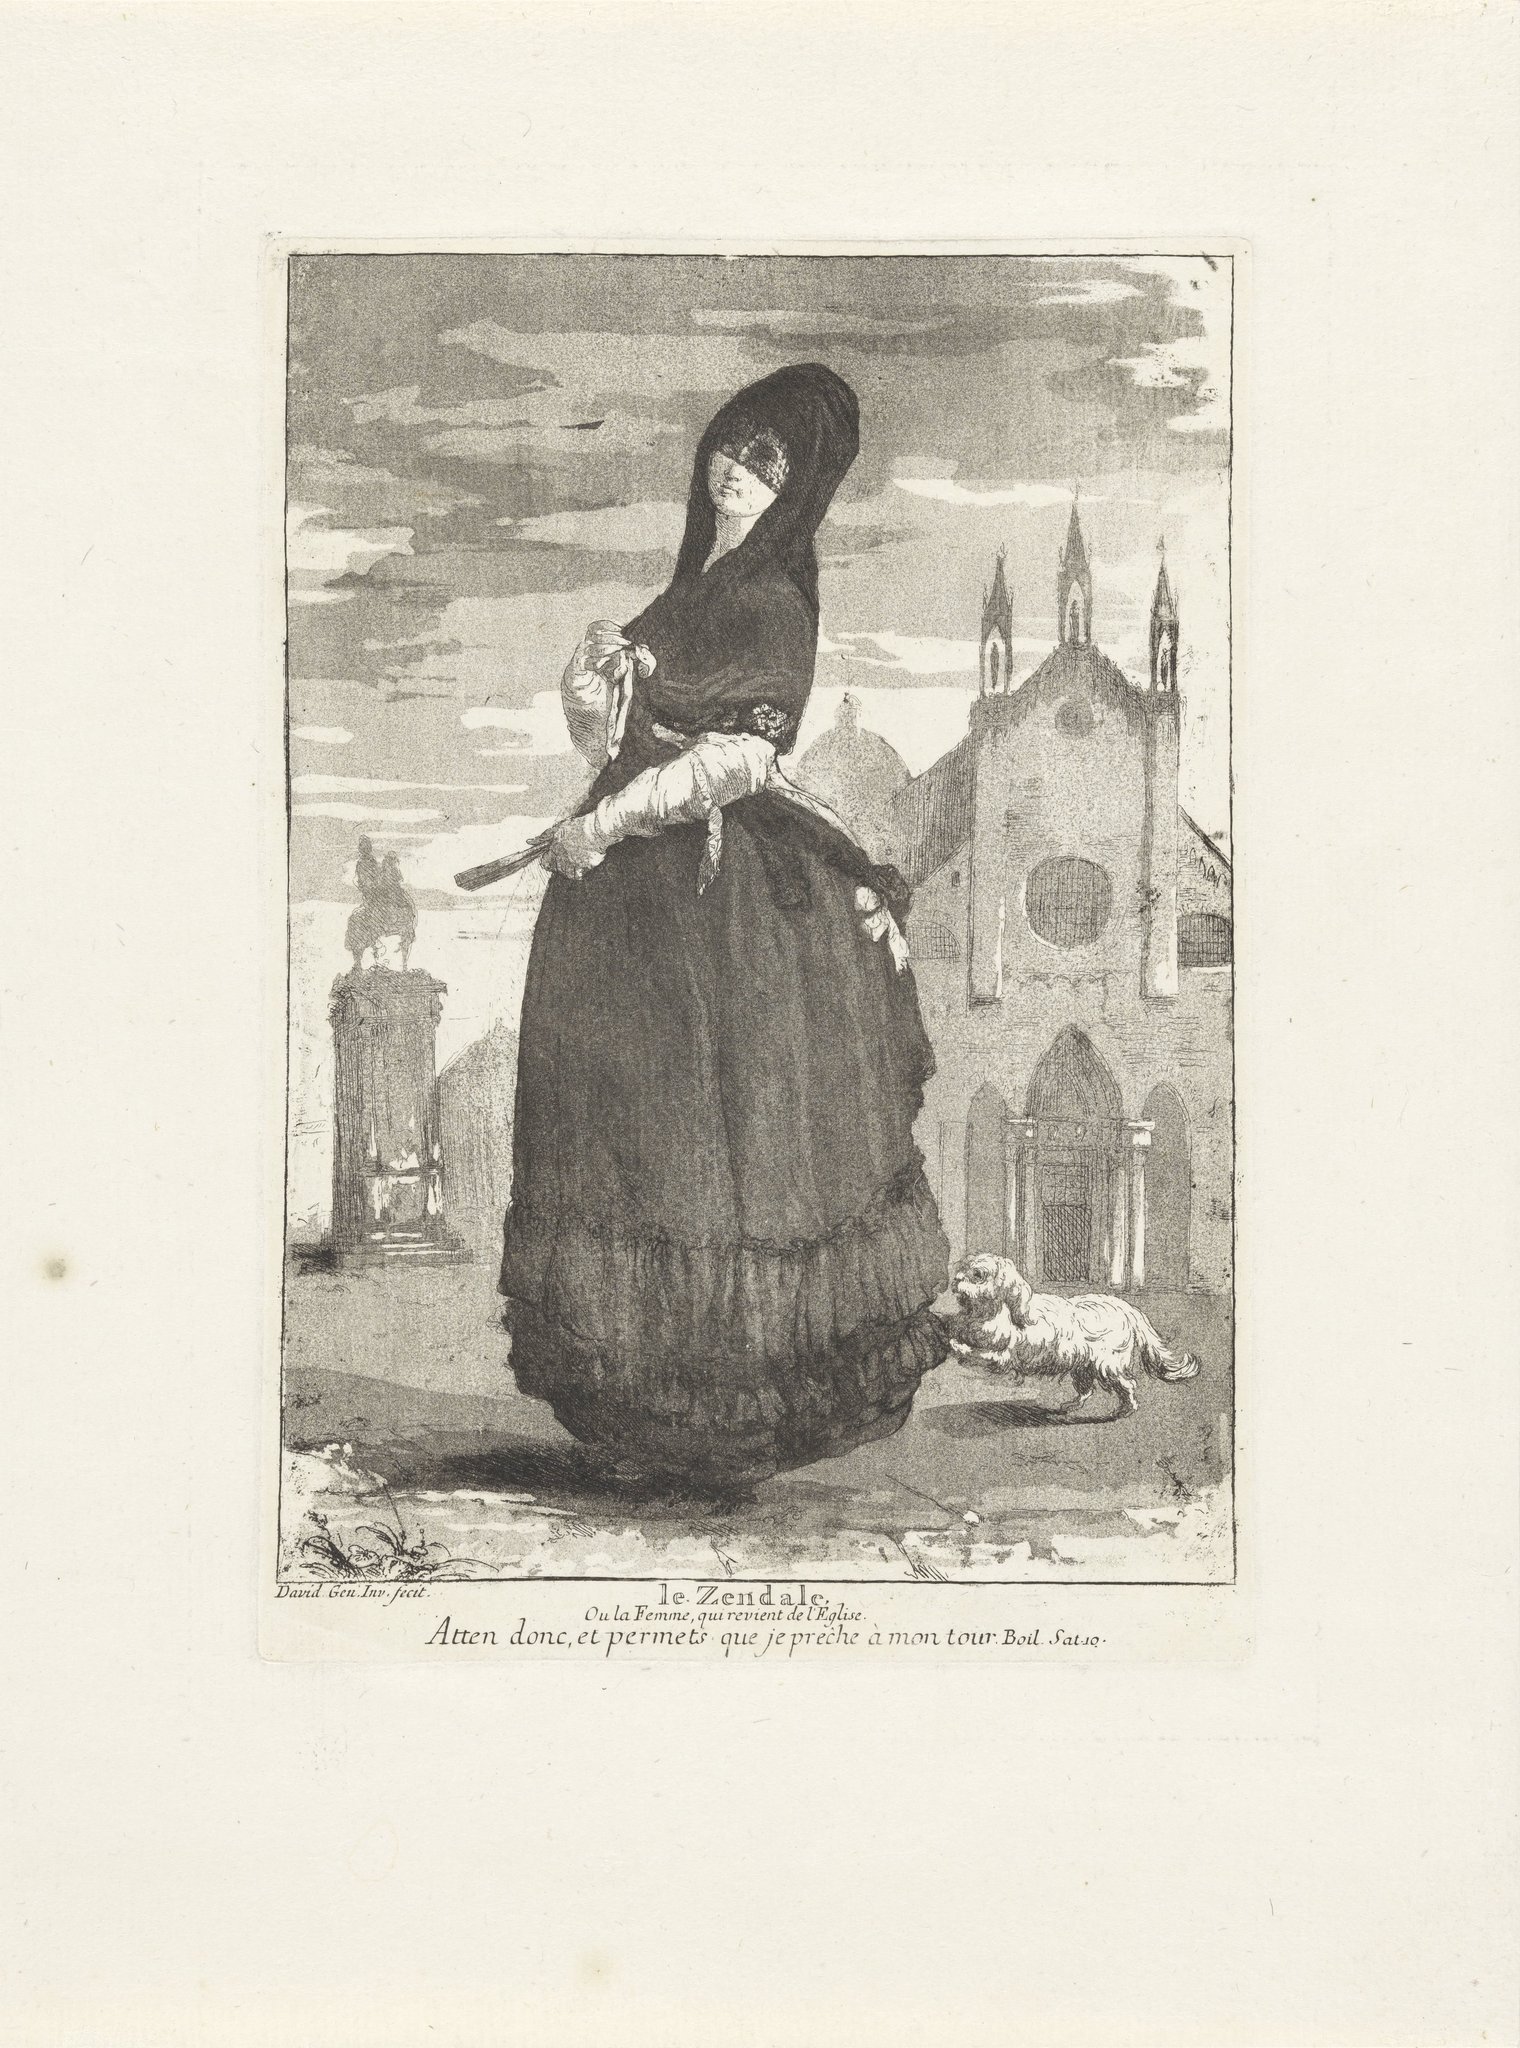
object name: print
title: Le Zendale, ou la Femme qui revient de l'Eglise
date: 1775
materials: paper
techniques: aquatint, etching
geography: venice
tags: going to church, church (exterior), folk costume, regional costume, dog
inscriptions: collector's mark: Lugt 2228, collector's mark: Lugt 2760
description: Vrouw in Venetiaans kostuum, met zendale en een waaier, voor de Santi Giovanni e Paolo en het monument voor Bartolomeo Colleoni te Venetië. Een hondje springt tegen de vrouw op. Titel in ondermarge.